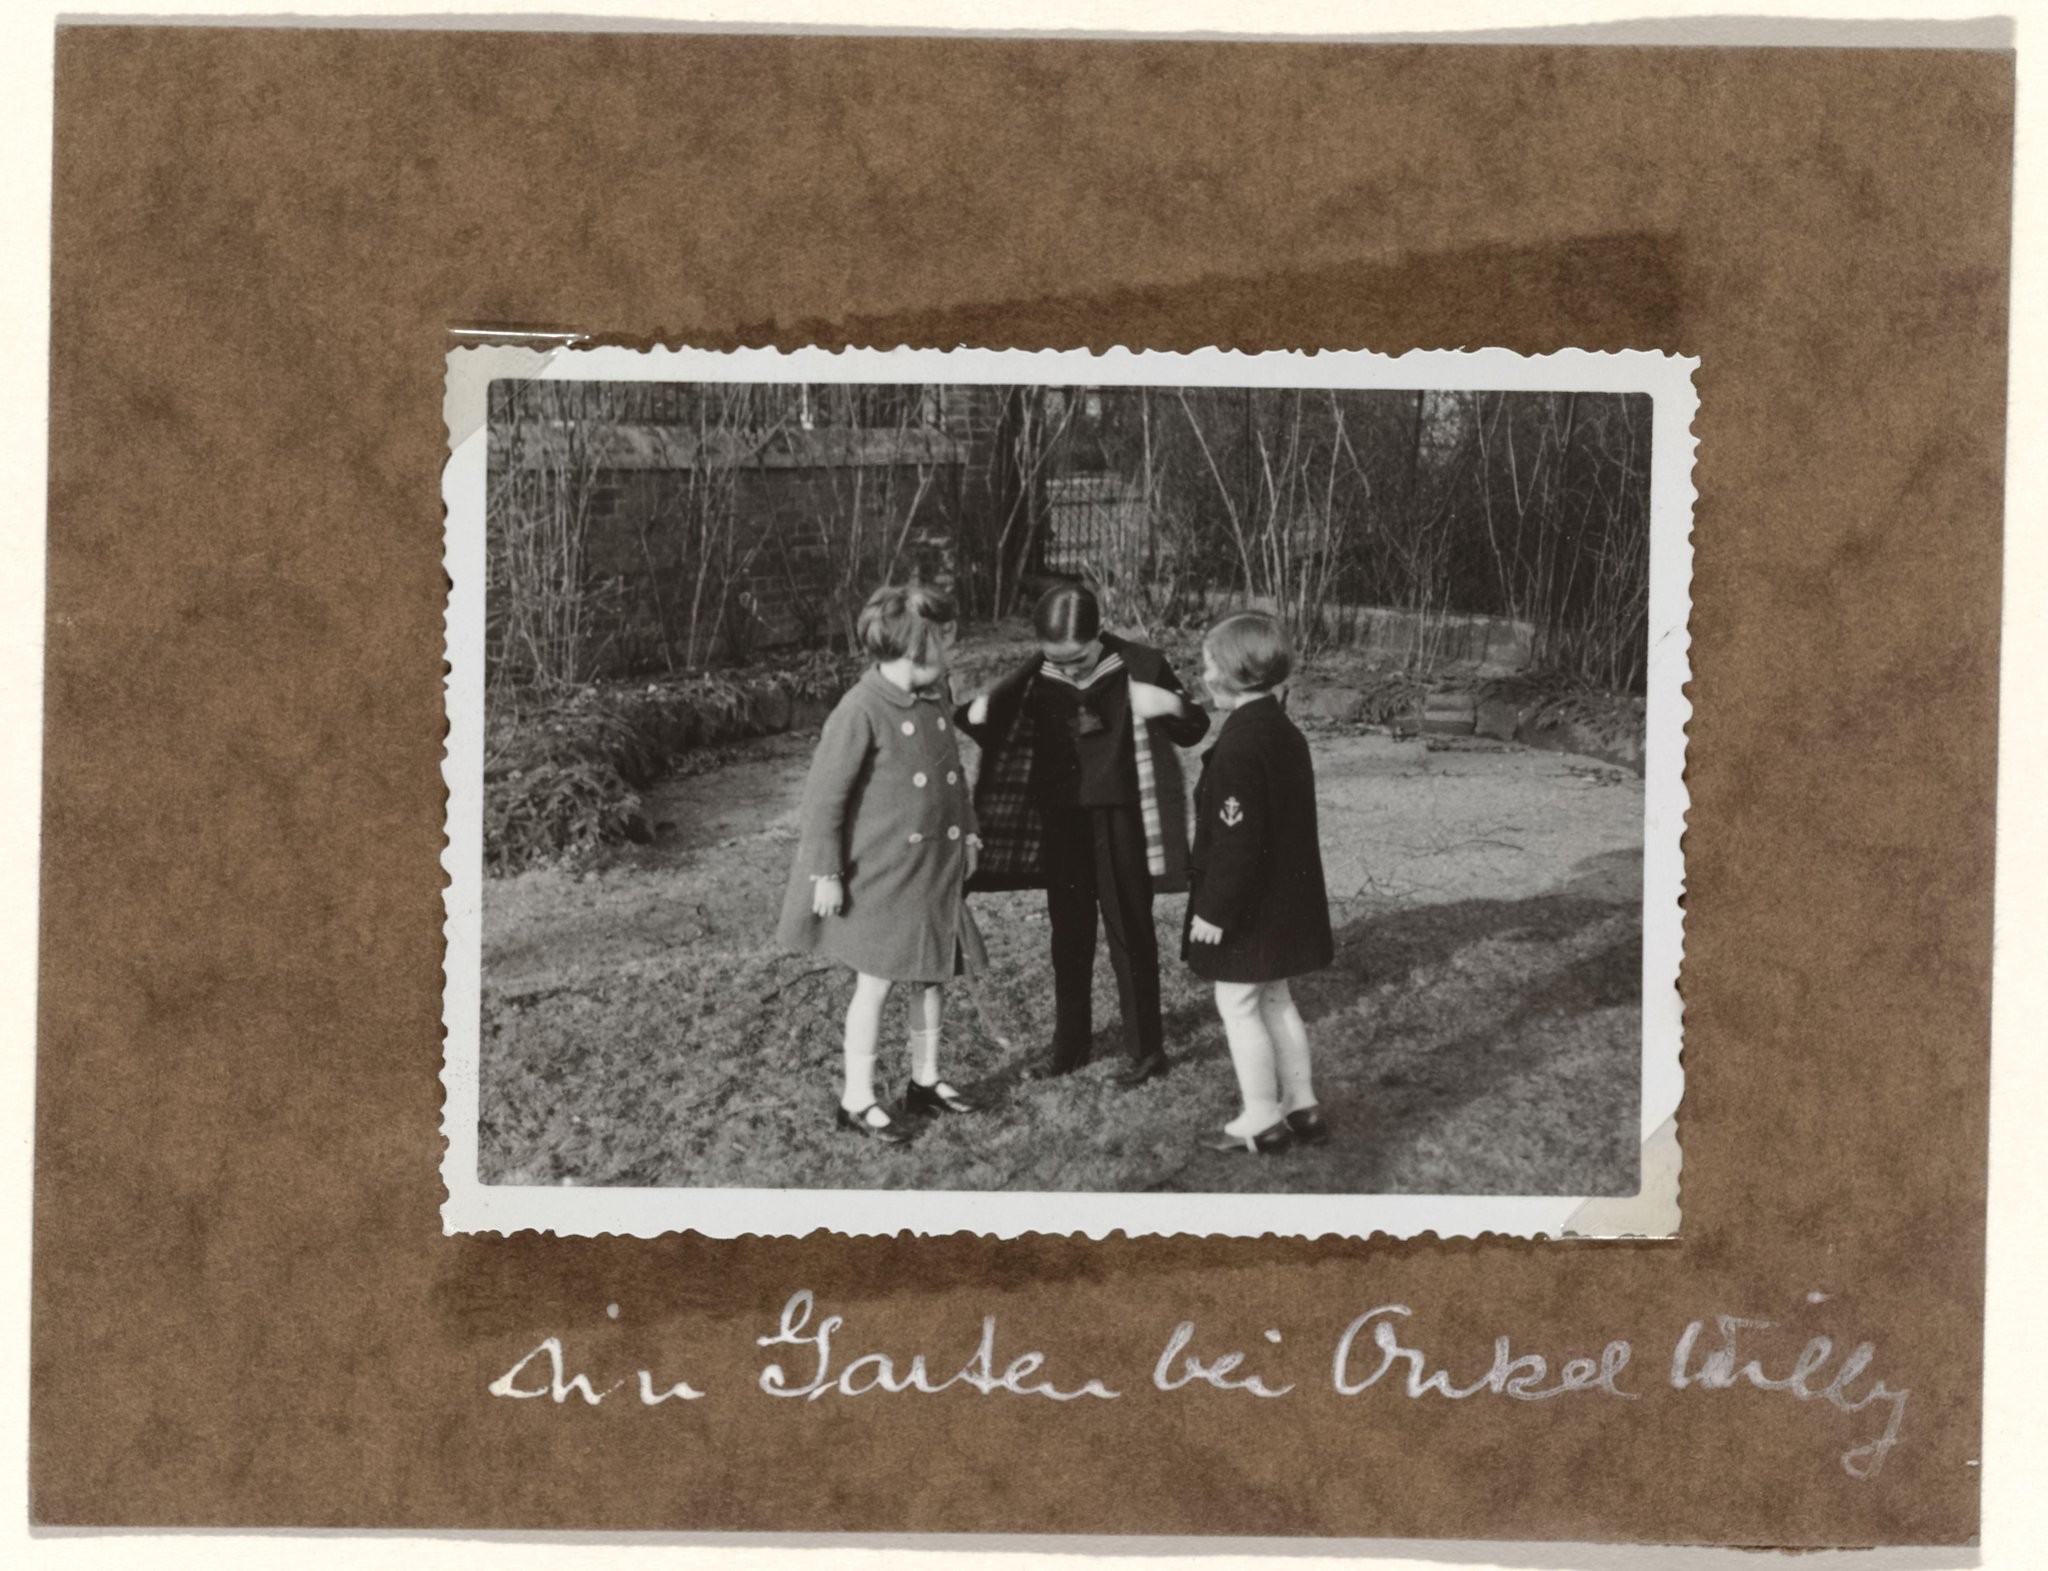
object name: photograph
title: Isabel Wachenheimer, Erica en Hansl in de tuin van de woning van Willy Moos in Hamburg, Bellevue 62, in maart-april 1935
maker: Anonymous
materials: photographic support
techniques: gelatin silver print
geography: hamburg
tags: leiden, isabel wachenheimer-elon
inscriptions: inscription: ‘In Garten bei Onkel Willy’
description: Isabel Wachenheimer (links), Erica (rechts) en Hansl (midden) in de tuin van de woning van Willy Moos in Hamburg.